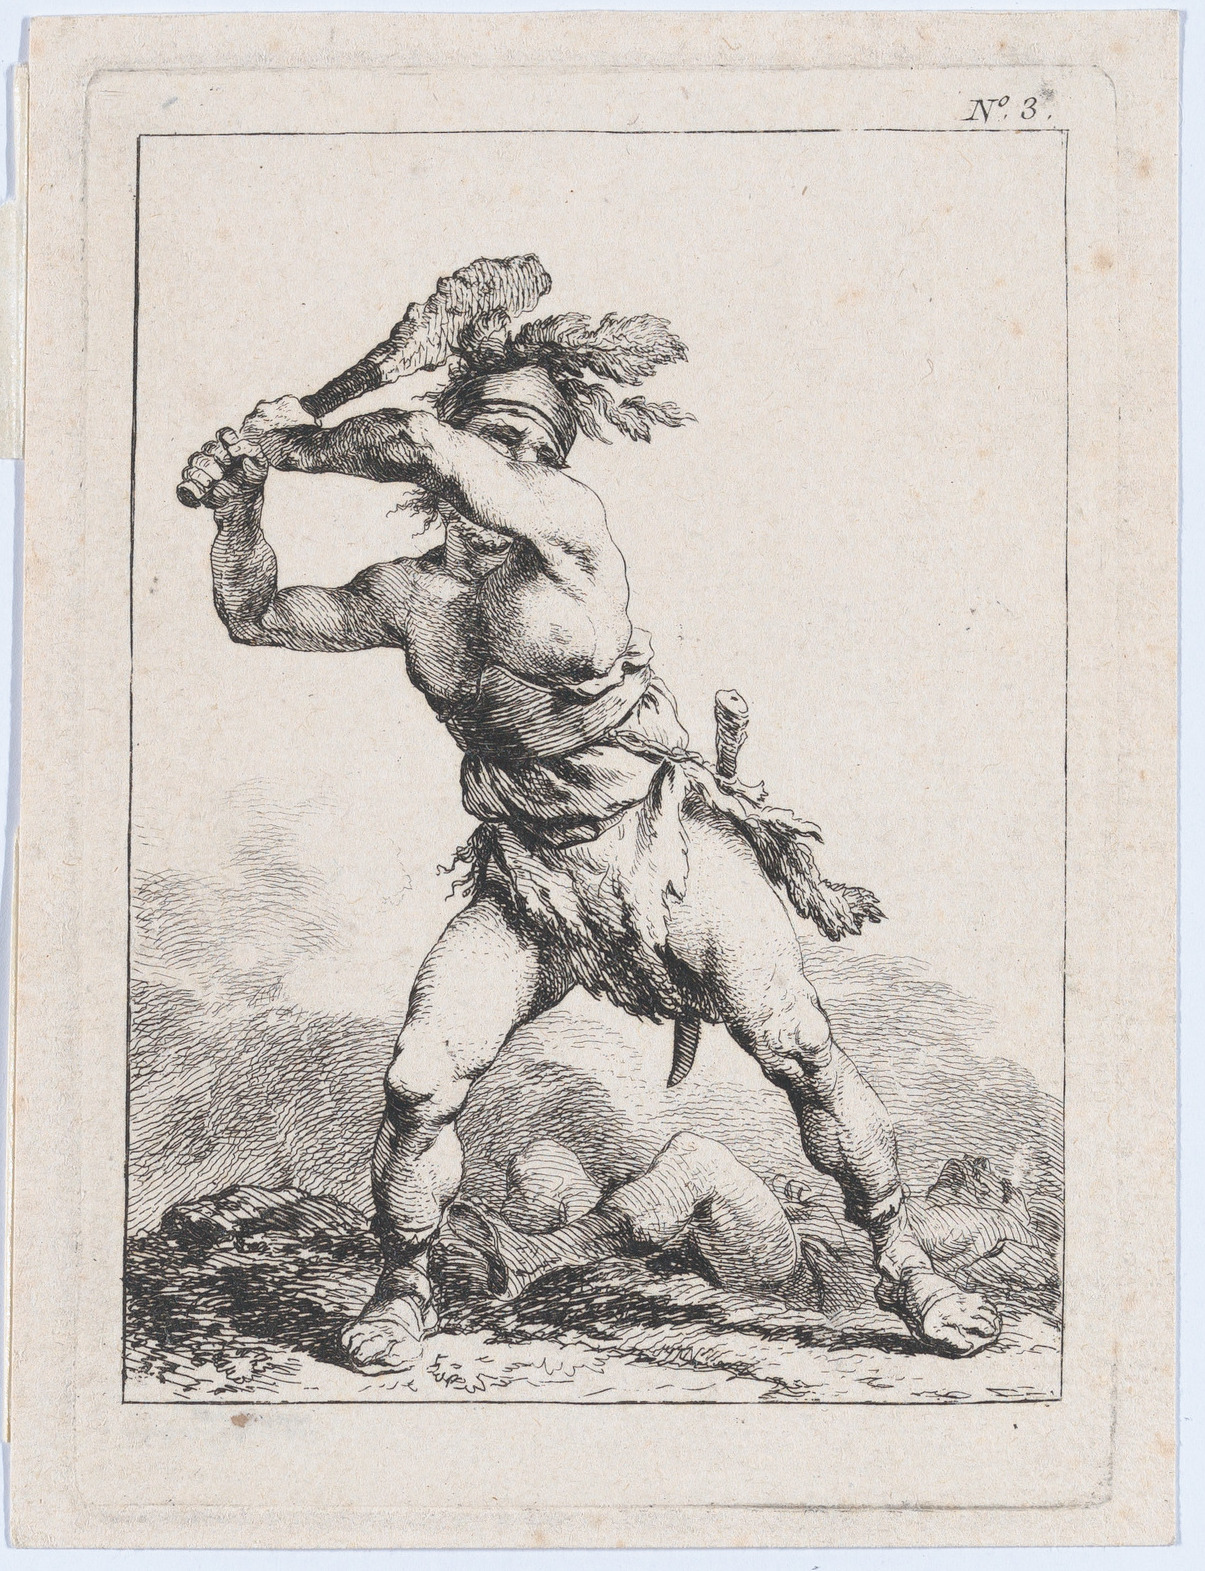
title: Savage Soldier Swinging a Club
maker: philippe jacques de loutherbourg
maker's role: artist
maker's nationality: french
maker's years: 1740-1812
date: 1755-1771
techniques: etching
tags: soldiers,men